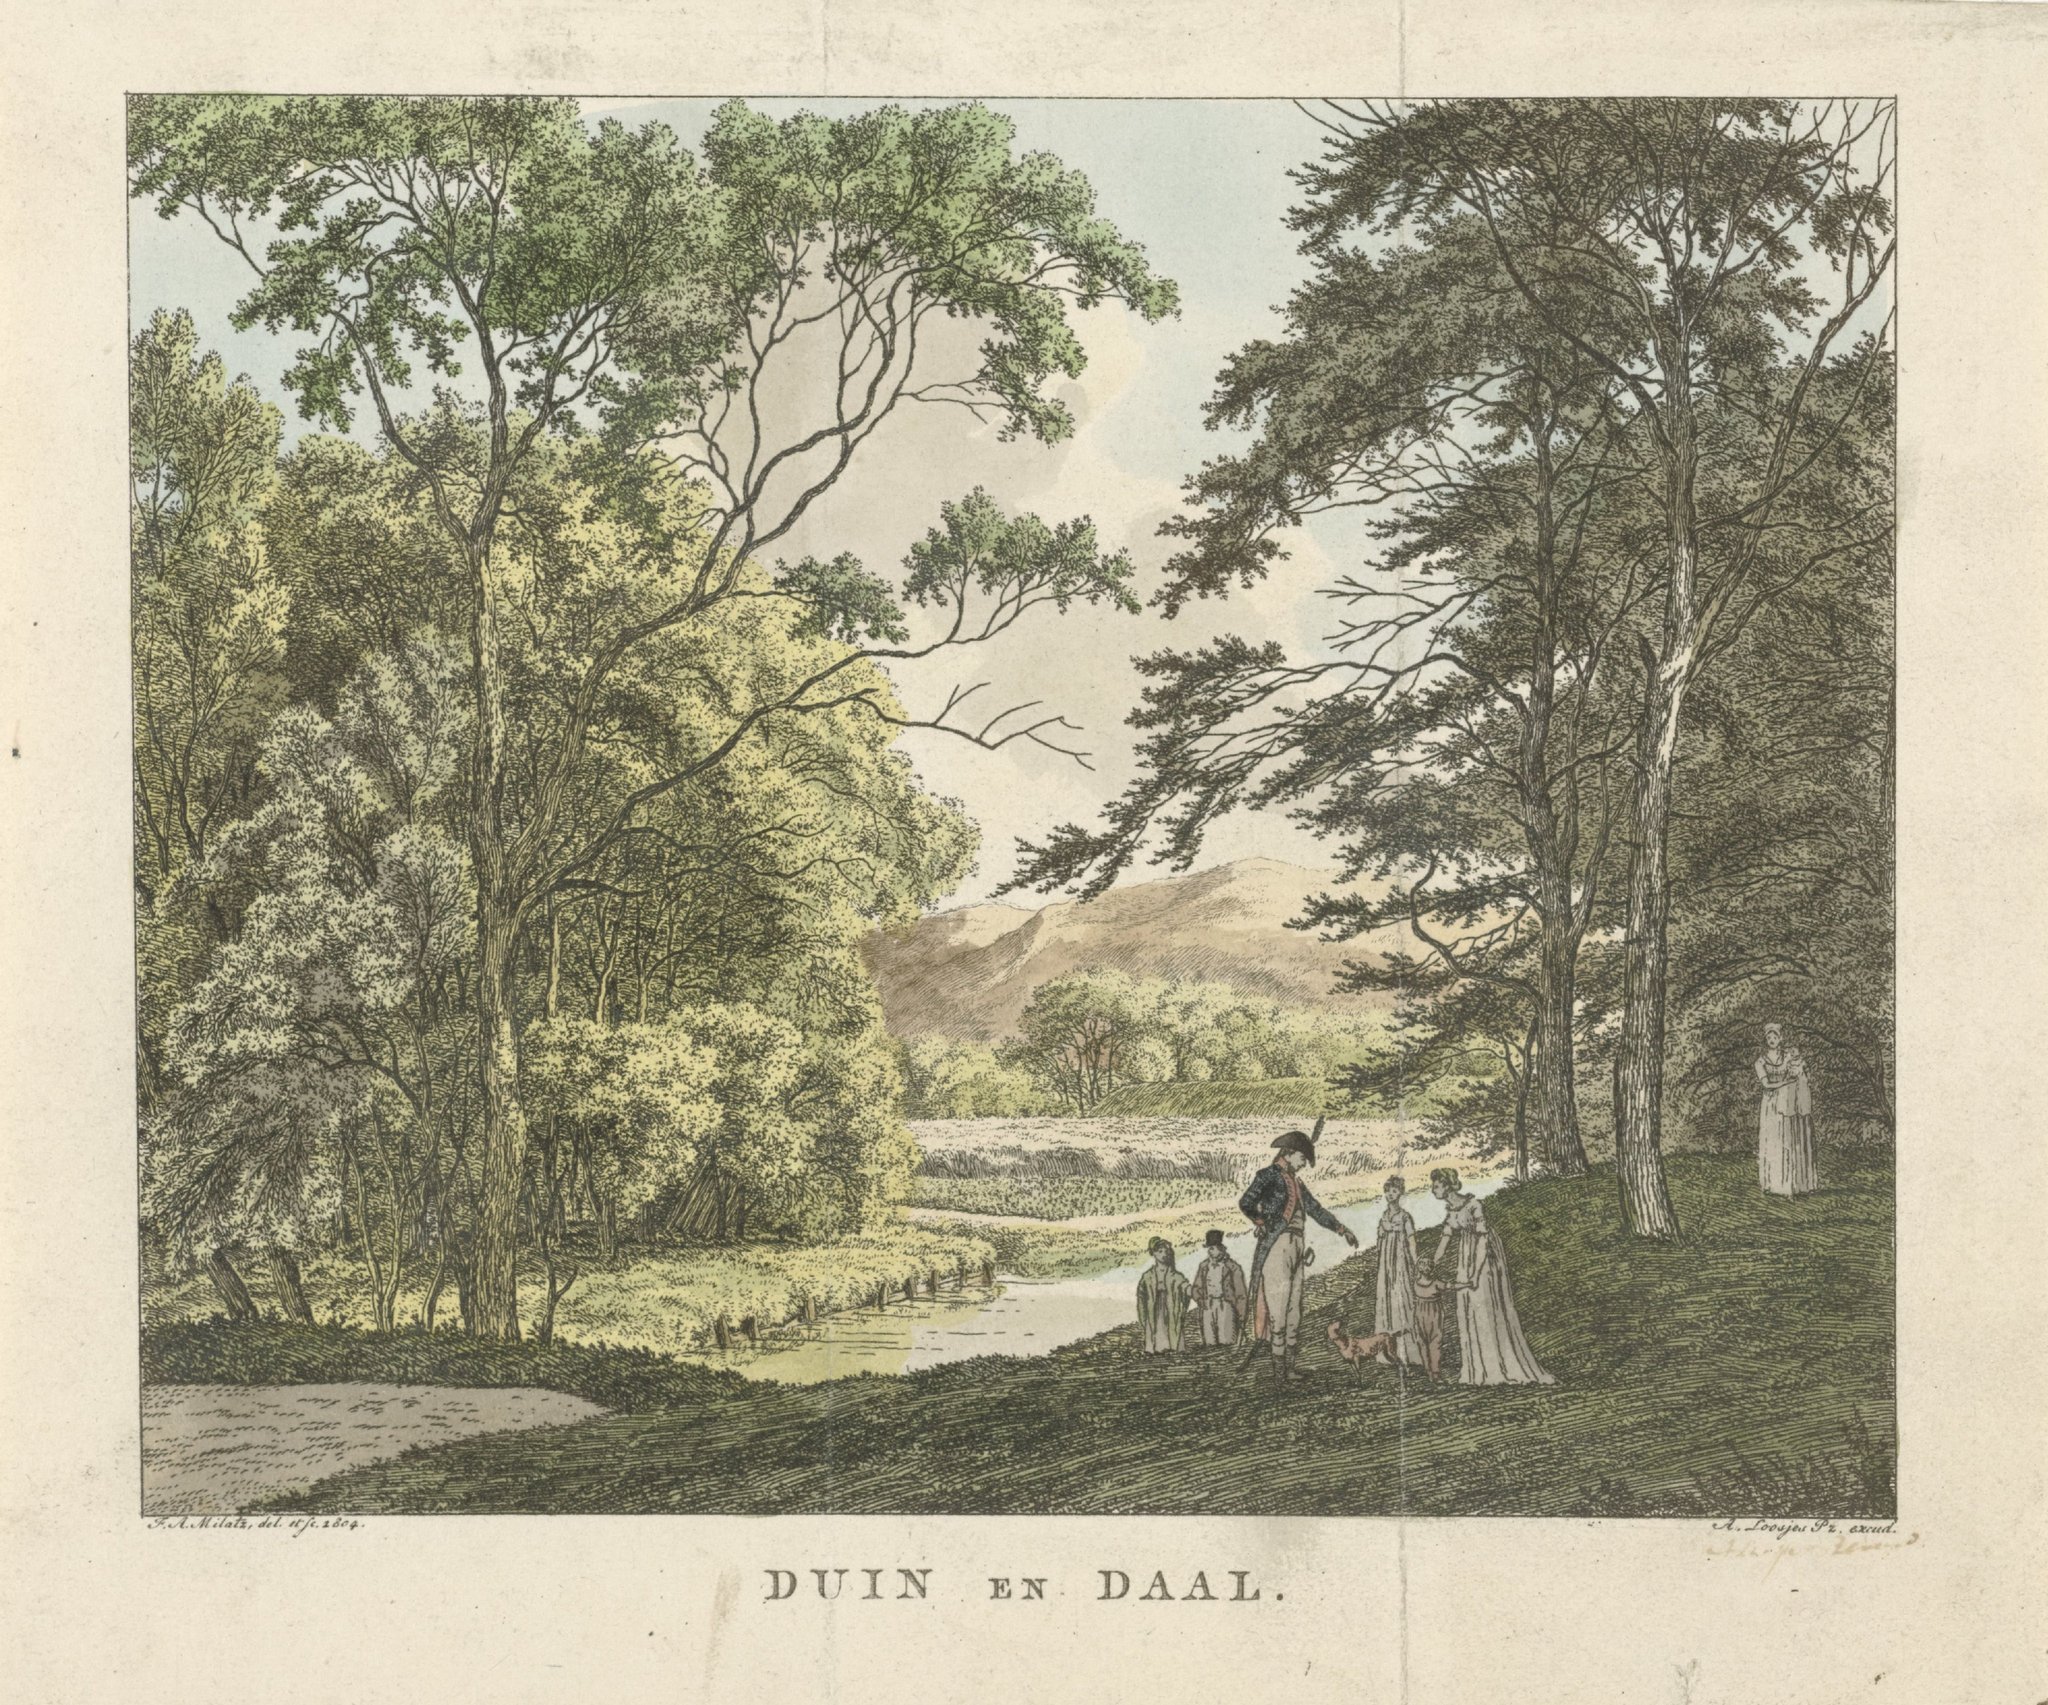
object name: print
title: Wandelaars bij buitenplaats Duin en Daal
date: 1804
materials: paper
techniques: brush, etching, hand coloring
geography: haarlem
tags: trees, walking, hiking (recreation), brook, dog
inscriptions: collector's mark: Lugt 2228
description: Prent gebruikt in: Adriaan Pietersz Loosjes en Jean Louis Pierre Leonard Freubel, Hollands Arkadia, of, Wandelingen in de omstreeken van Haarlem, Haarlem 1804, afb. na p. 366.